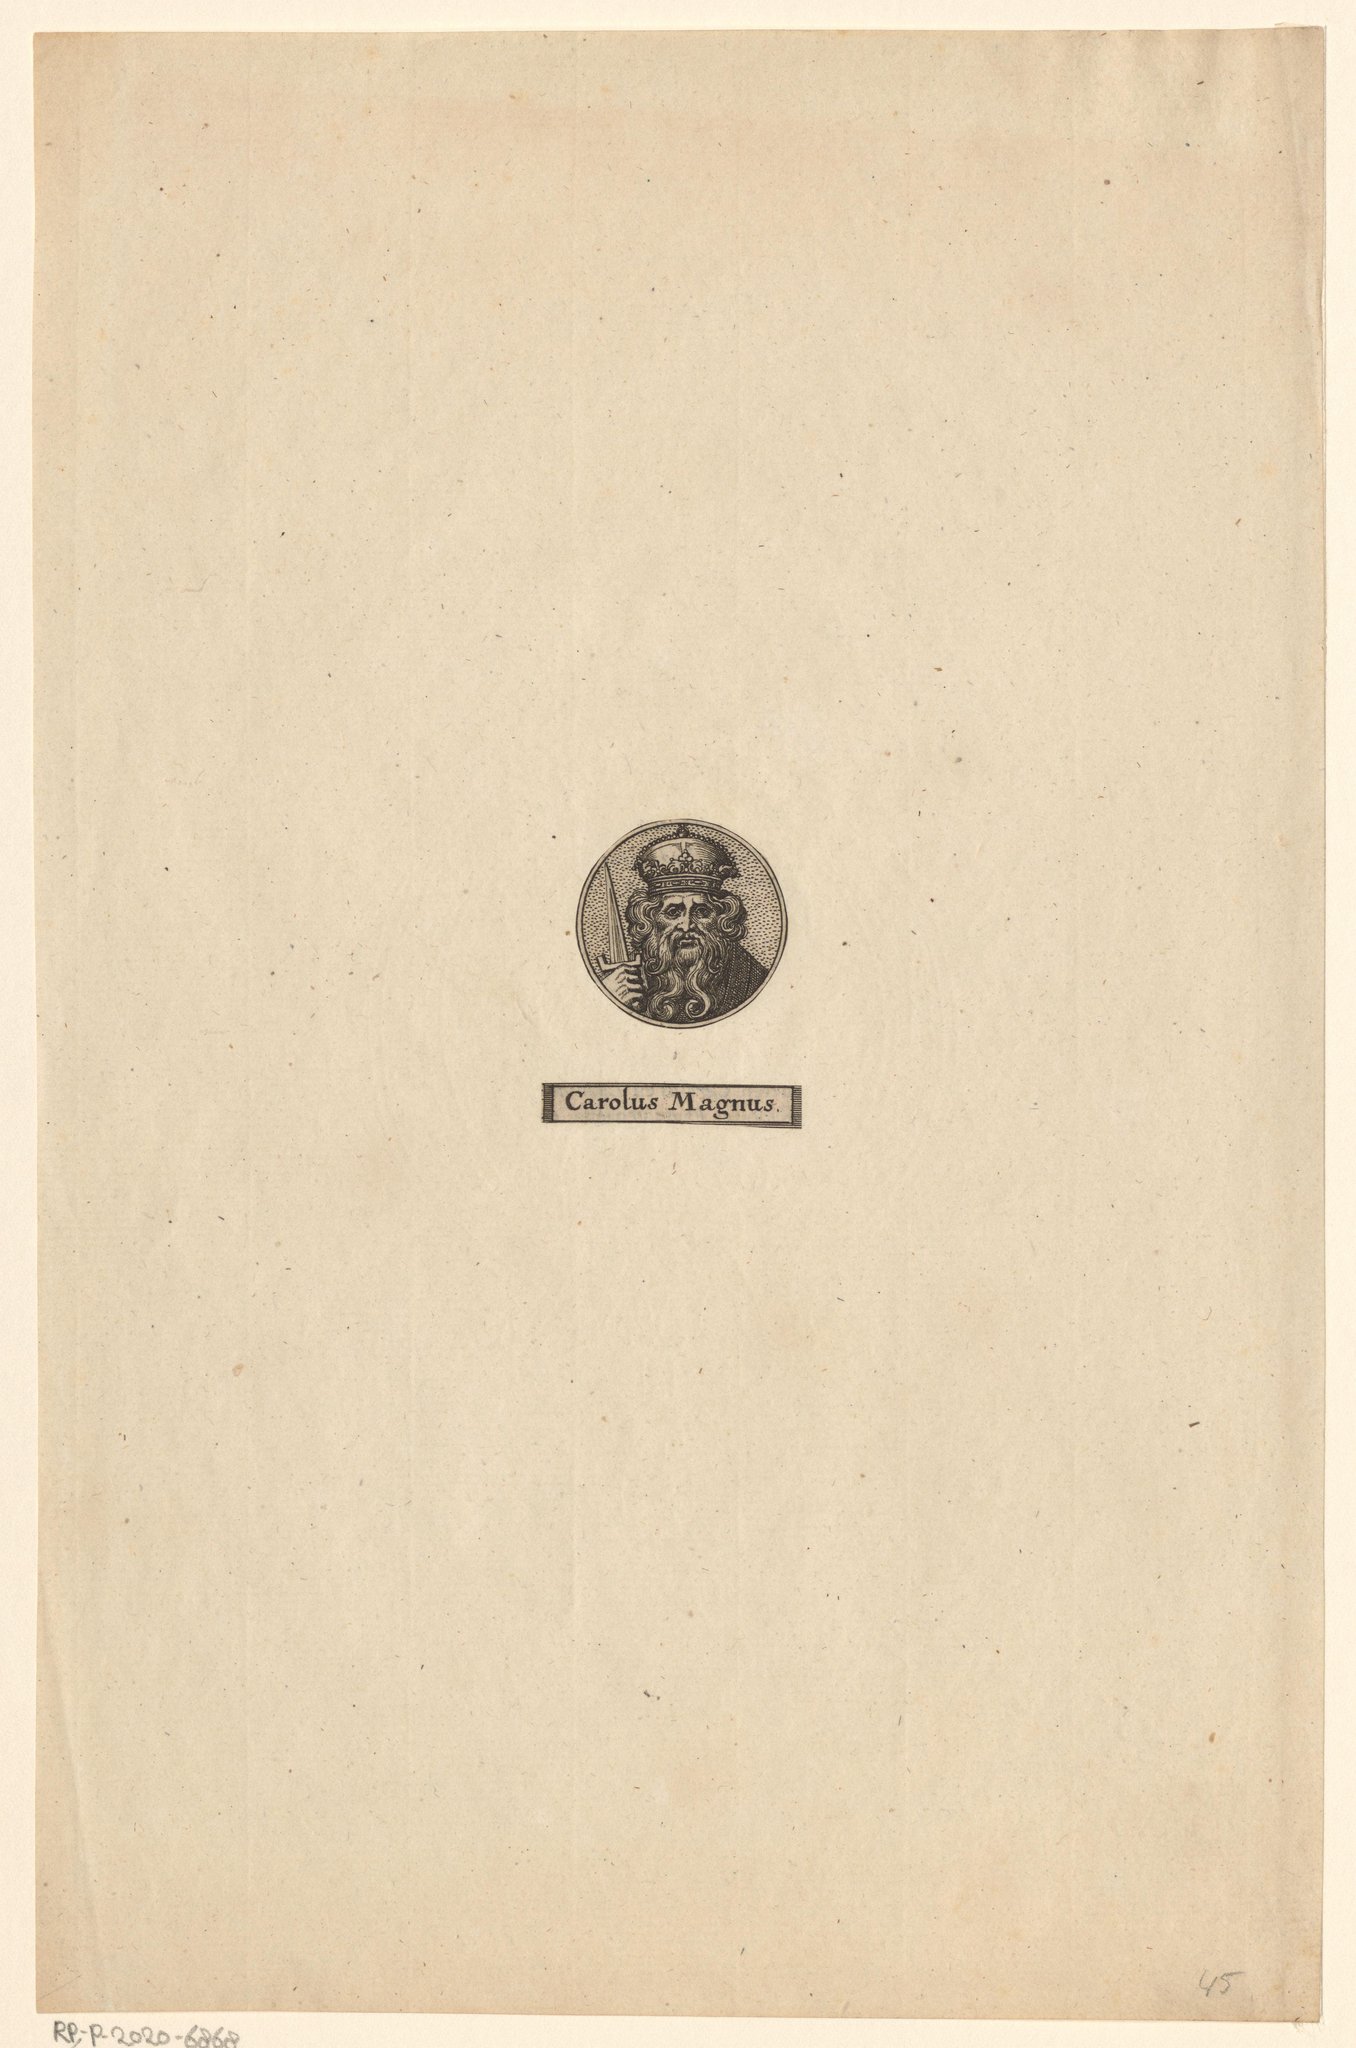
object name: print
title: Portret van Karel de Grote, keizer van het Heilige Roomse Rijk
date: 1660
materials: paper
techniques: etching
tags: charlemagne (holy roman emperor), historical persons, king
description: Prent gebruikt in: Gottfried, Johan Ludwig en Simon de Vries. Historische kronyck: vervattende een nauwkeurige en volkomene beschrijvingh der aldergedenck waerdiste geschiedenissen des weerelds (...). Leiden: weduwe Joannes Brouwer en Jacobus van Meurs, 1660. Prent ook gebruikt in latere edities. De prent maakt onderdeel uit van een grotere plaat met 24 portretten.